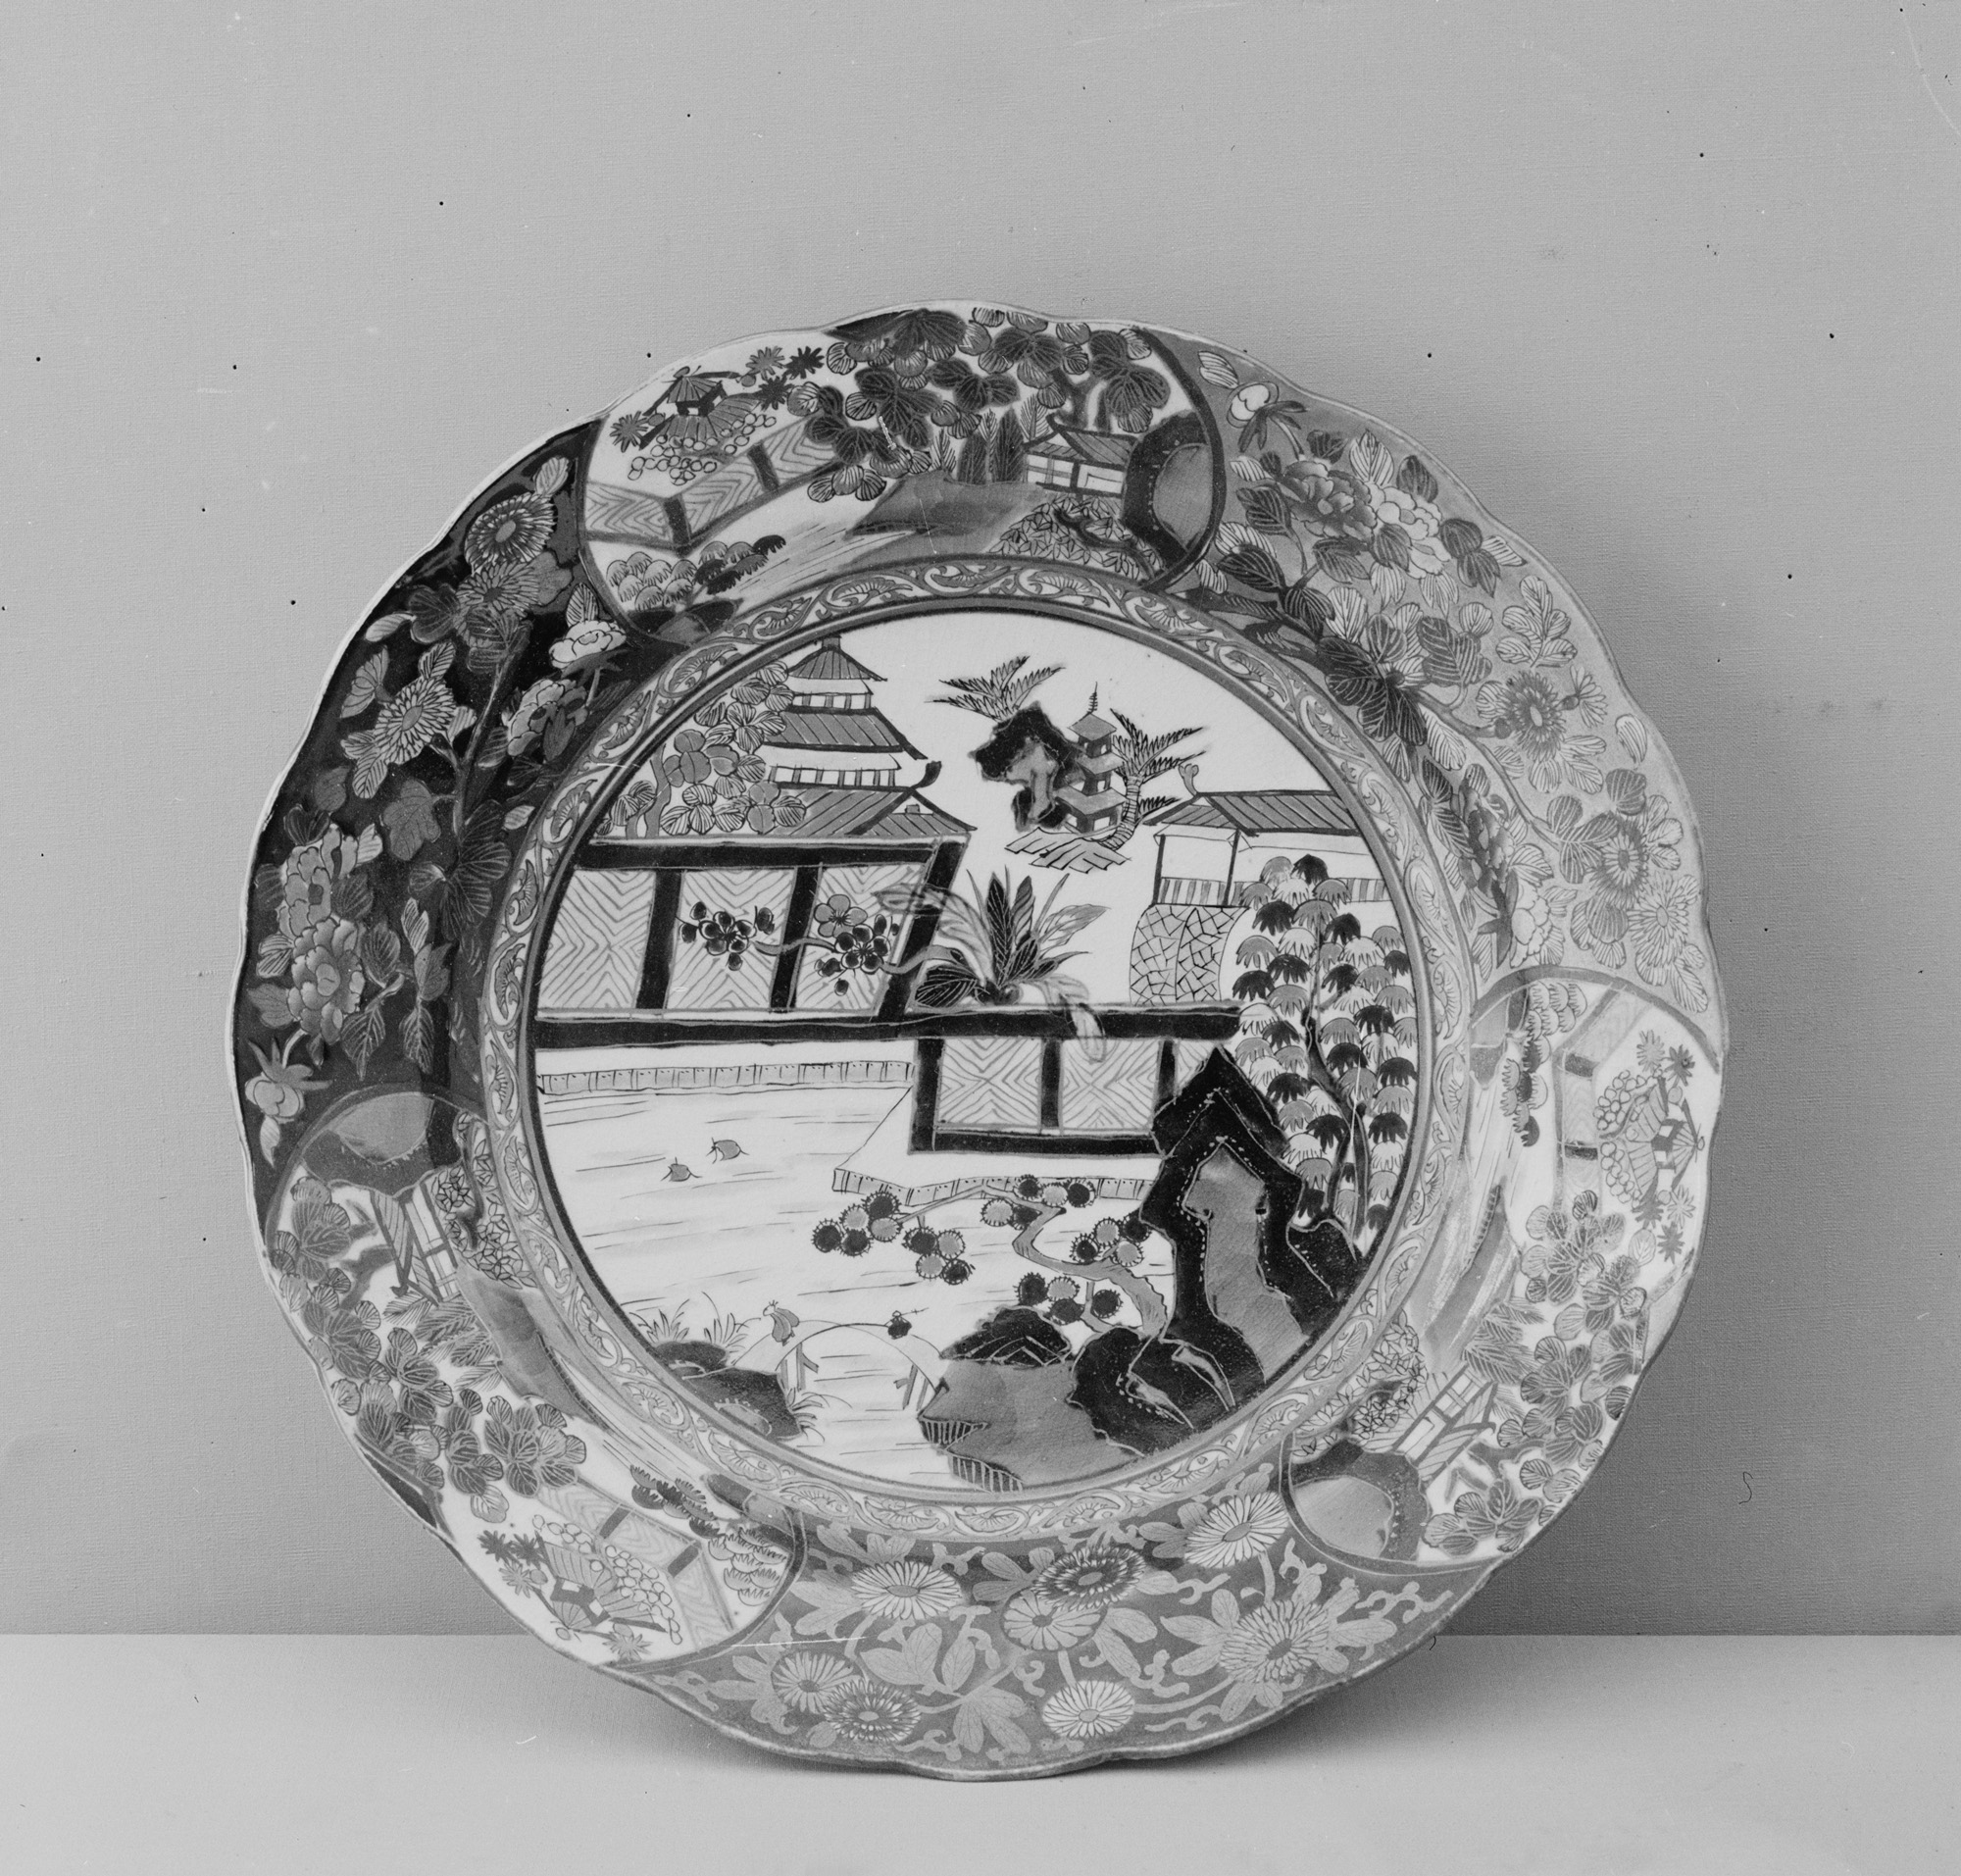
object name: dish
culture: japanese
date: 1730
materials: enamel, glaze, porcelain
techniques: polychrome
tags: houses,flowers